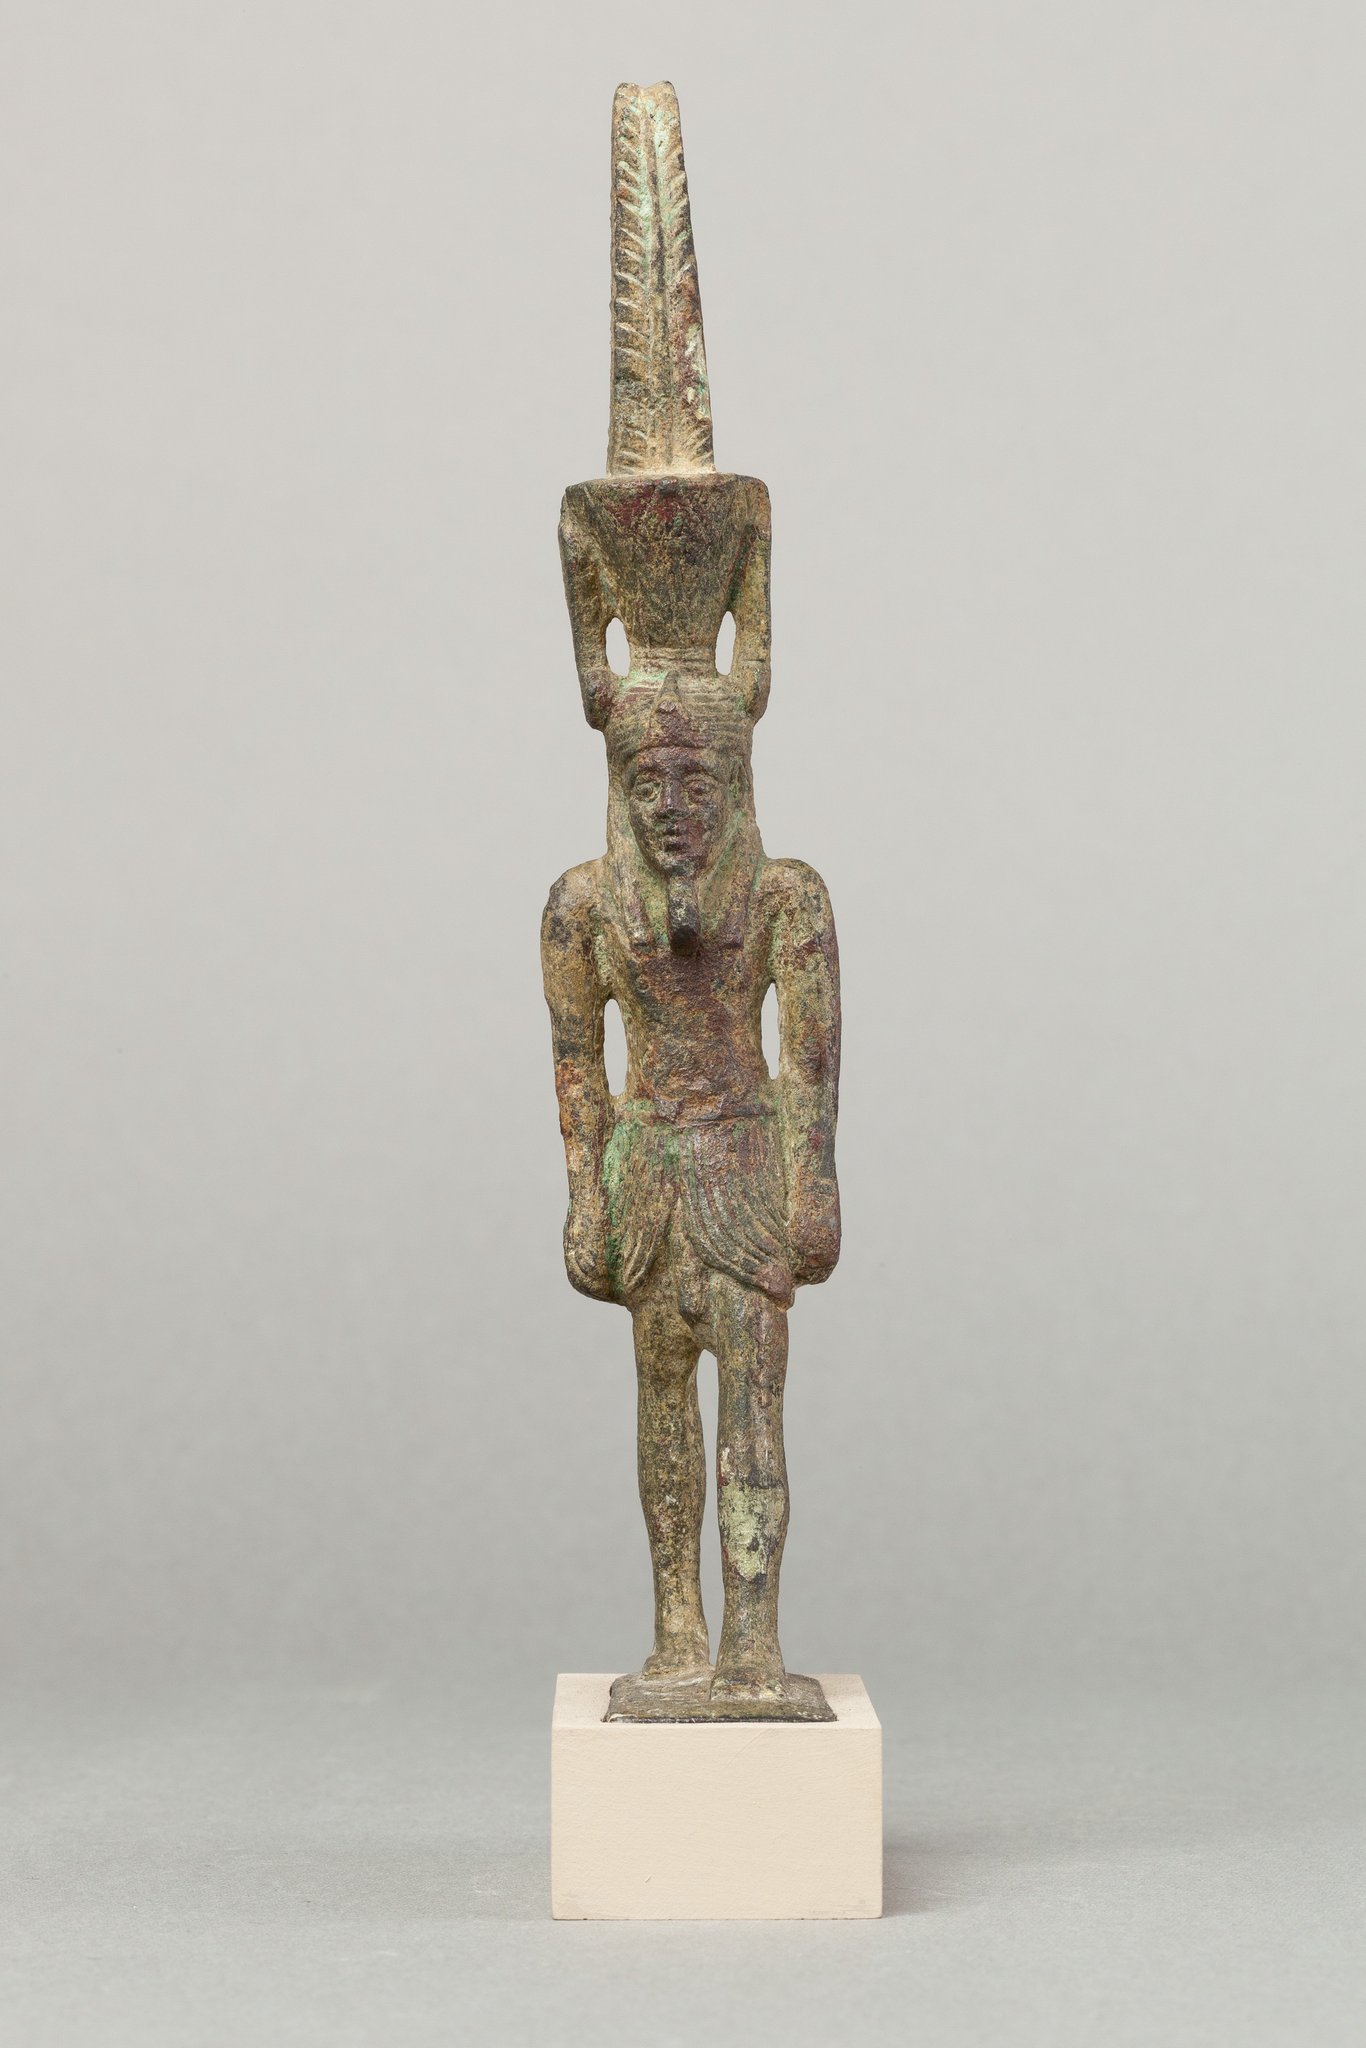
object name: statuette, nefertum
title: Nefertum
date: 664-630 BCE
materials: metal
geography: egypt